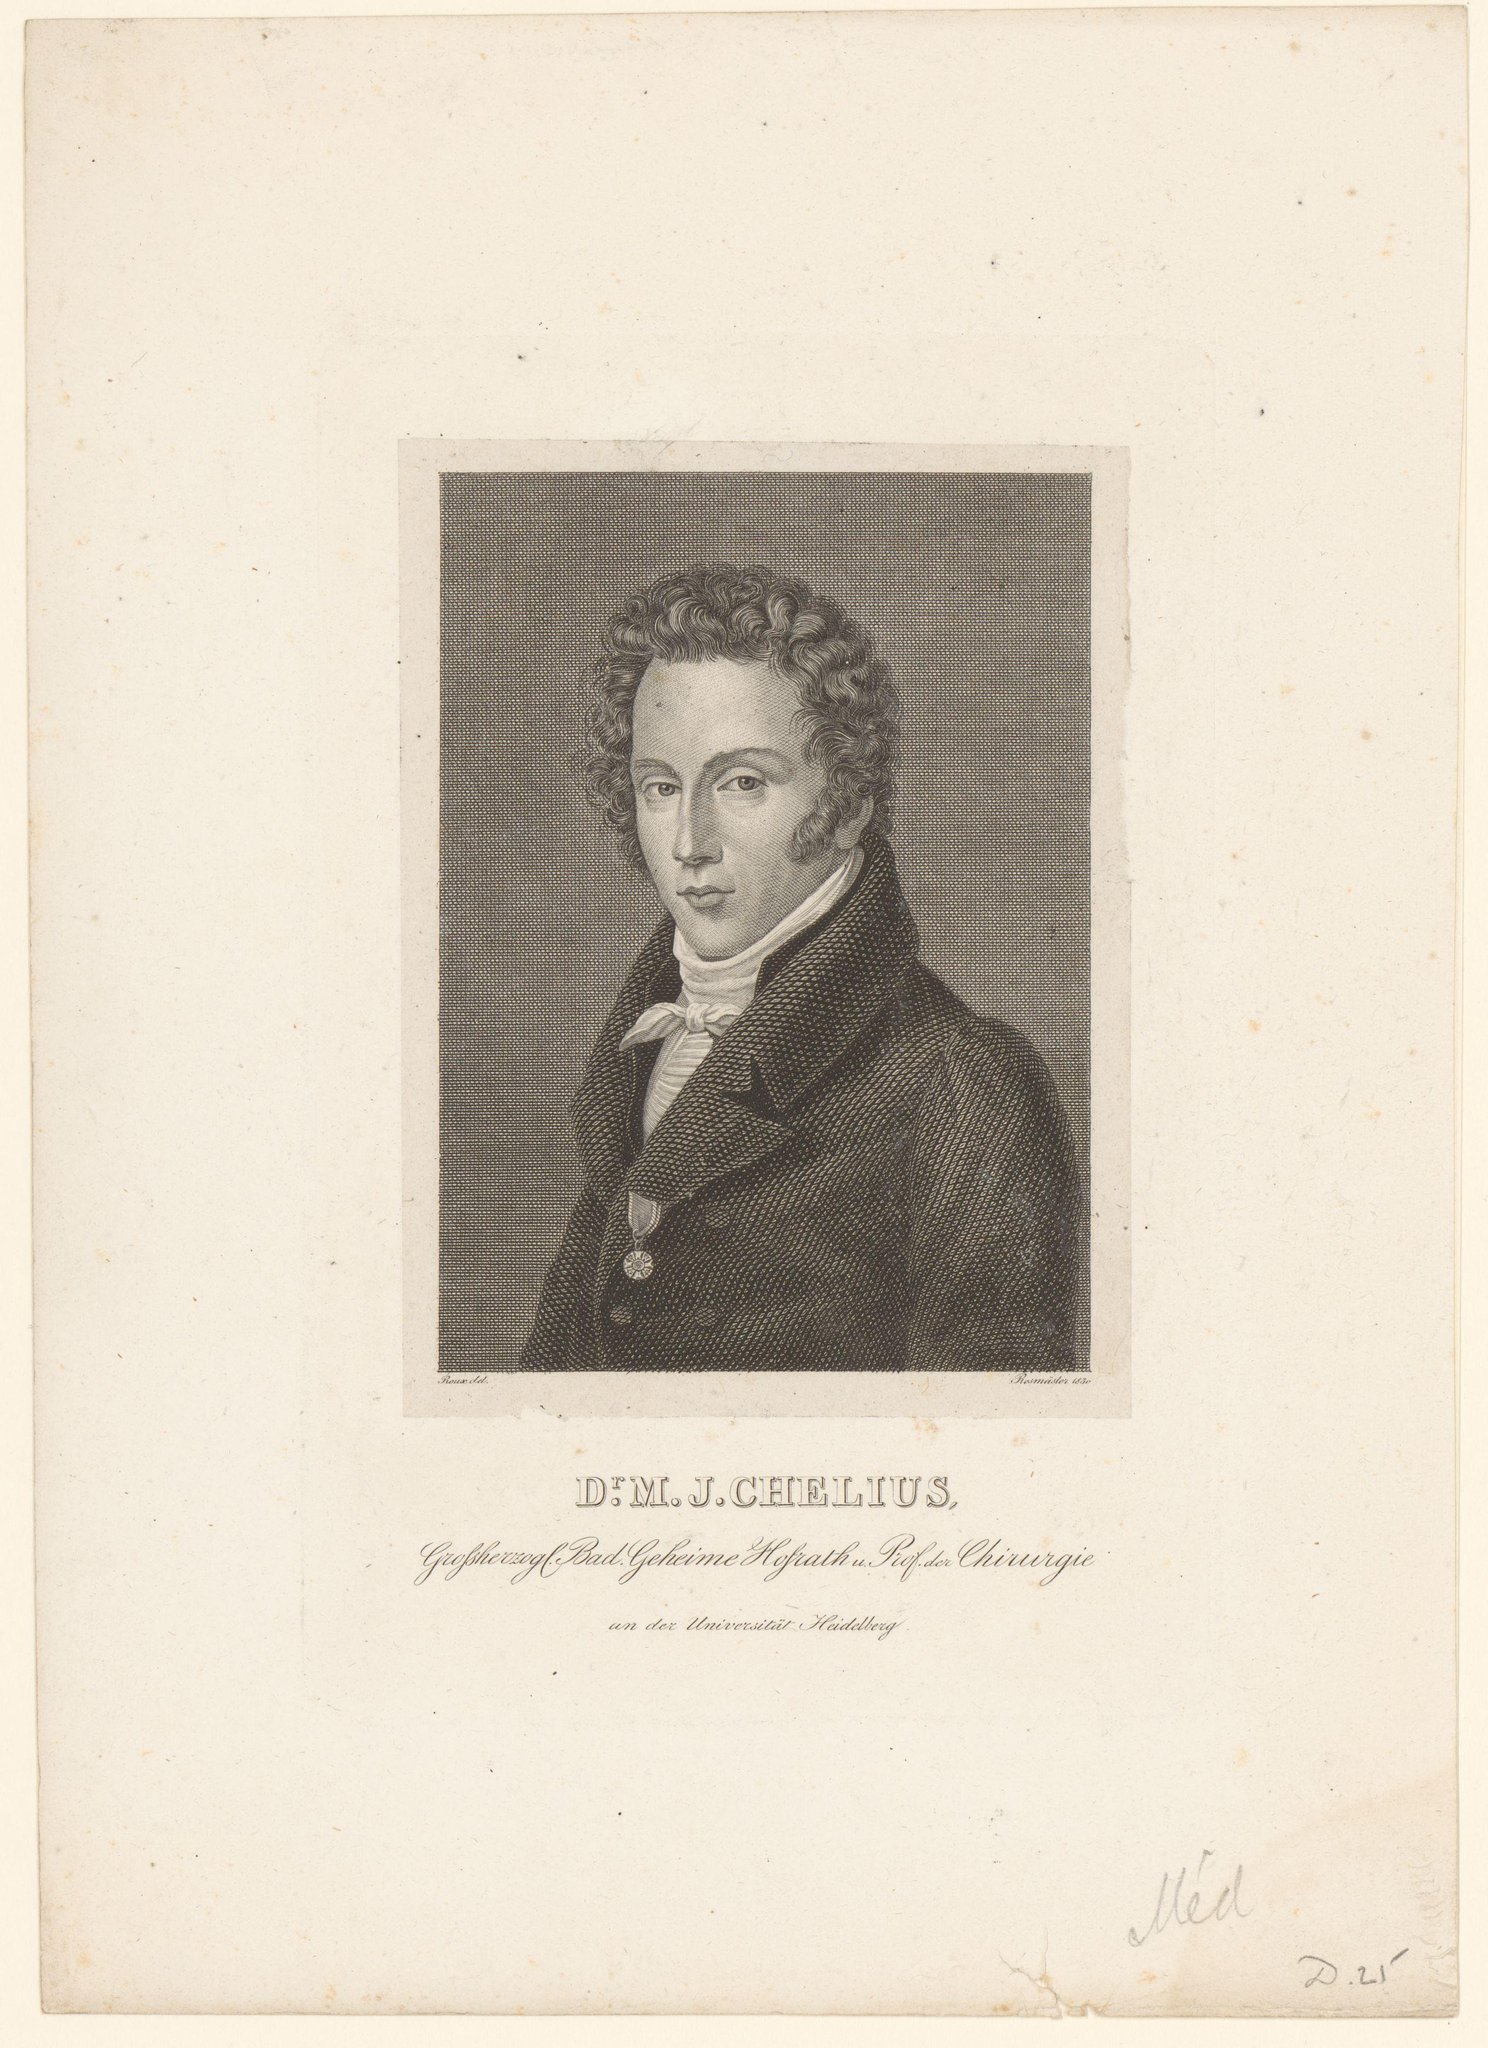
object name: print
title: Portret van Maximilian Joseph Chelius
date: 1785-1858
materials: paper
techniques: engraving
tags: historical persons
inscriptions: collector's mark: Lugt 2228